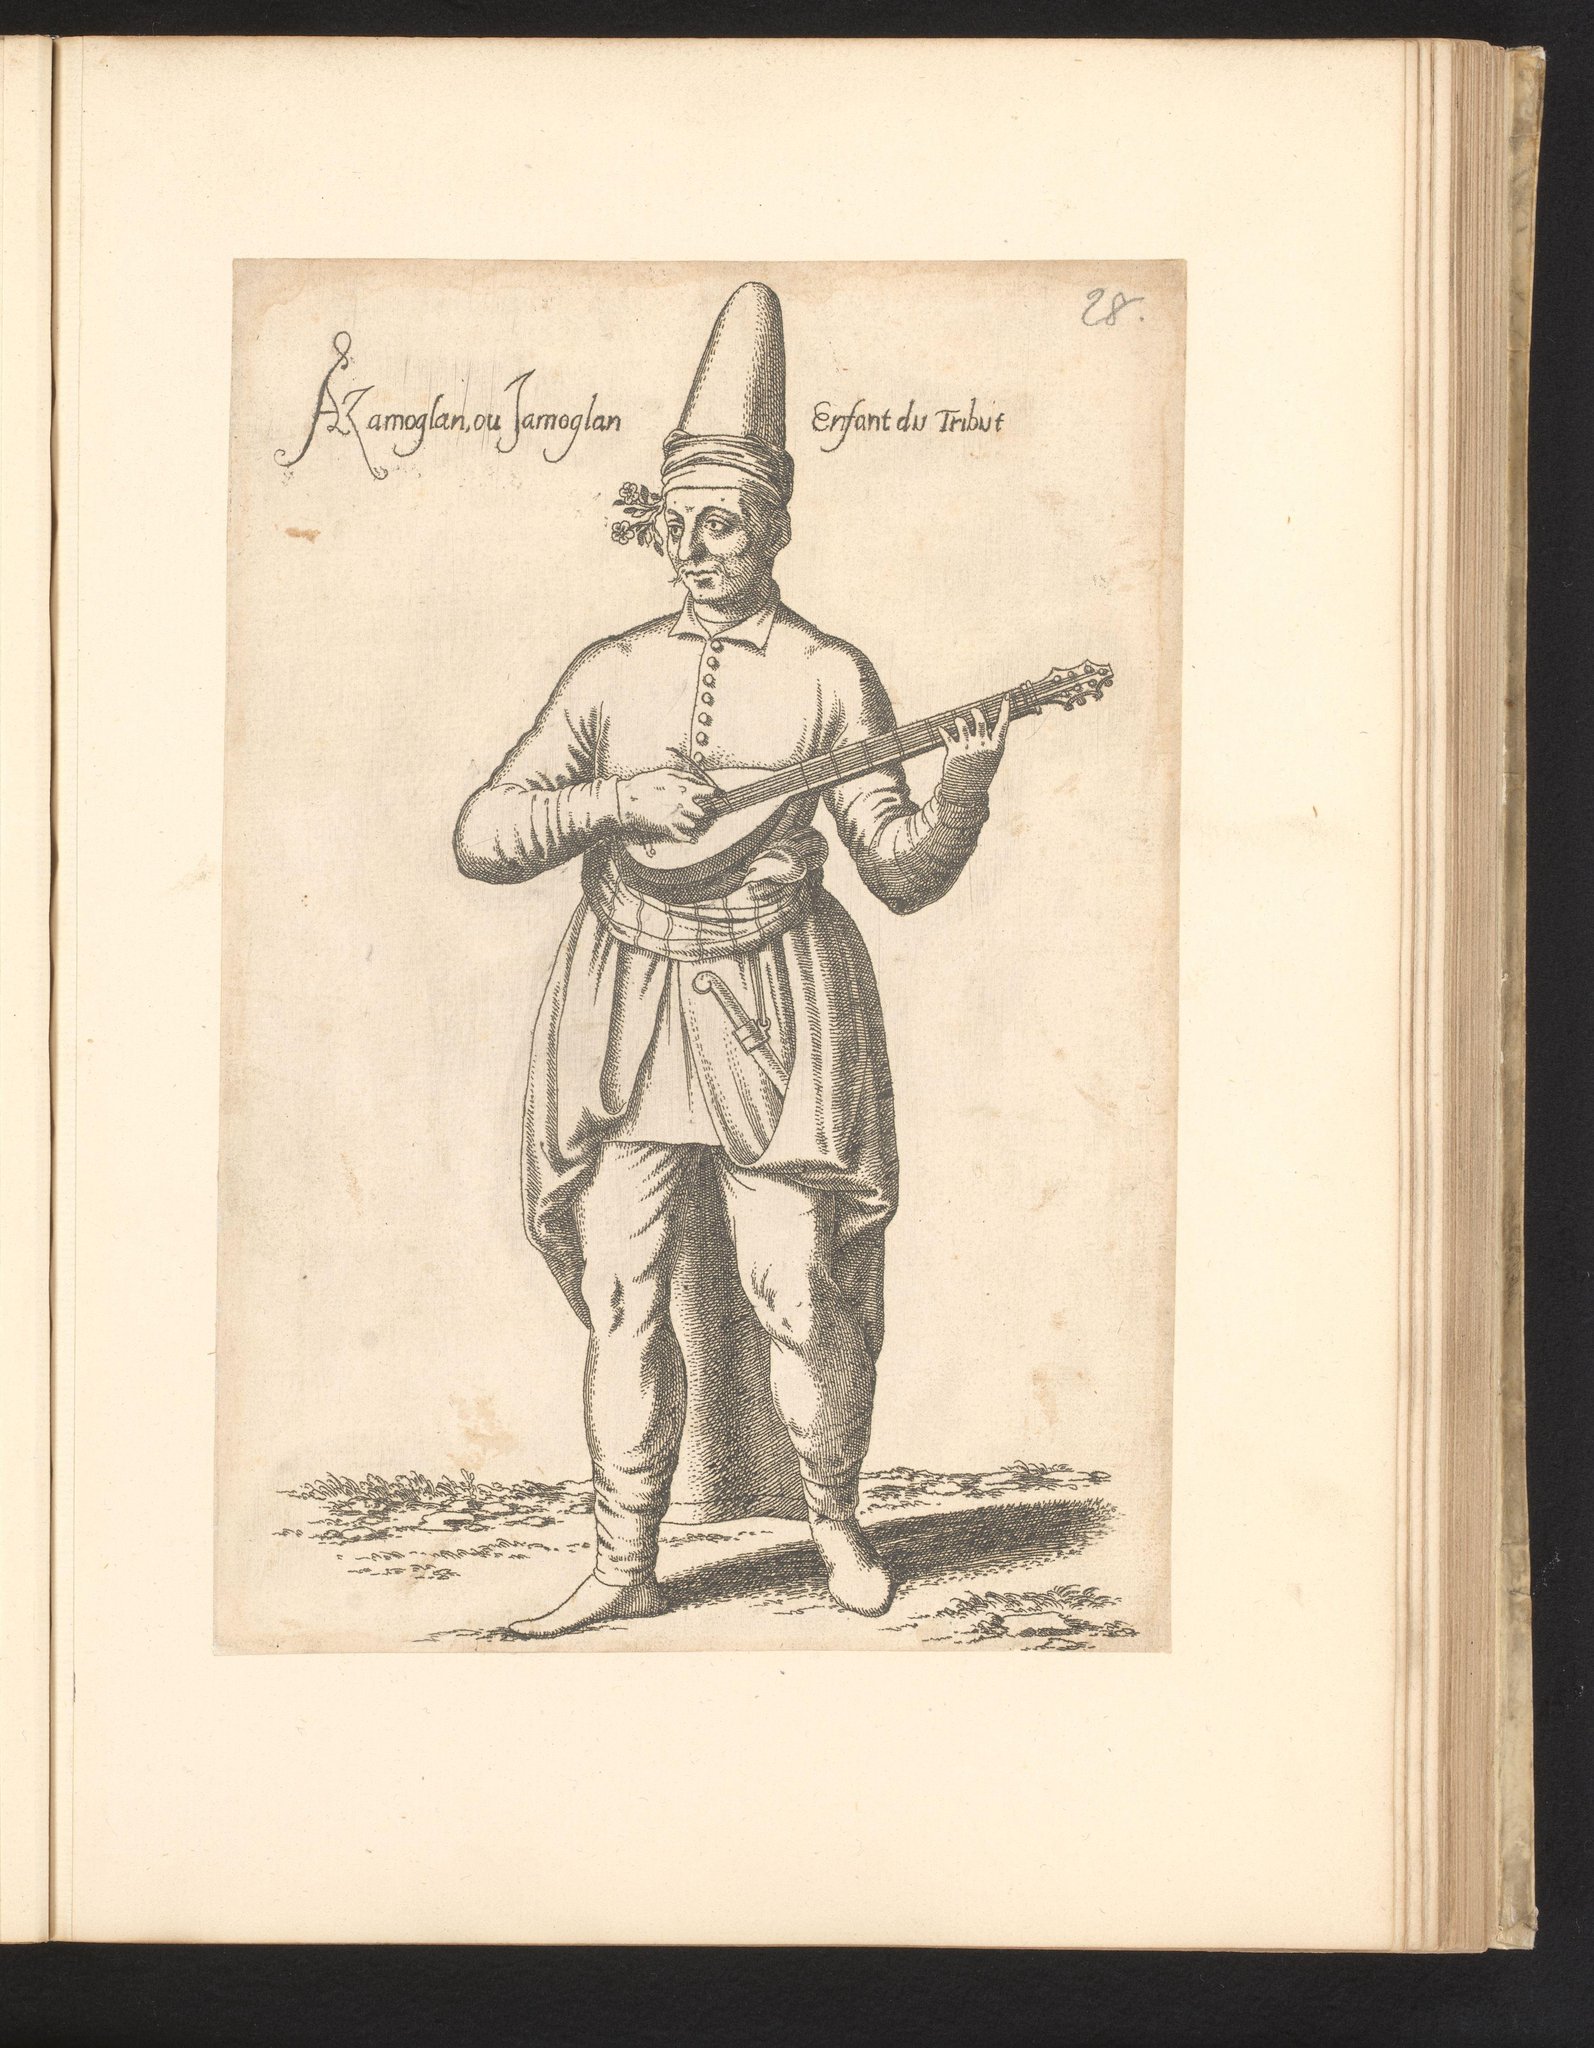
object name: print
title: Gitaar spelende 'Azamoglan' of 'Jamoglan'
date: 1555-1568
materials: paper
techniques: etching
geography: lyon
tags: cook, asiatic races and peoples: turks (+ costume)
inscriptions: collector's mark: Lugt 2760, collector's mark: Lugt 2228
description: Prent uit: Nicolay, Nicolas de. Les quatre premiers livres des navigations et pérégrinations orientales, de N. de Nicolay, (...) Avec les figures au naturel tant d'hommes que de femmes selon la diversité des nations, & de leur port, maintien & habitz. Lyon: Guillaume (I) Rouille, 1568.